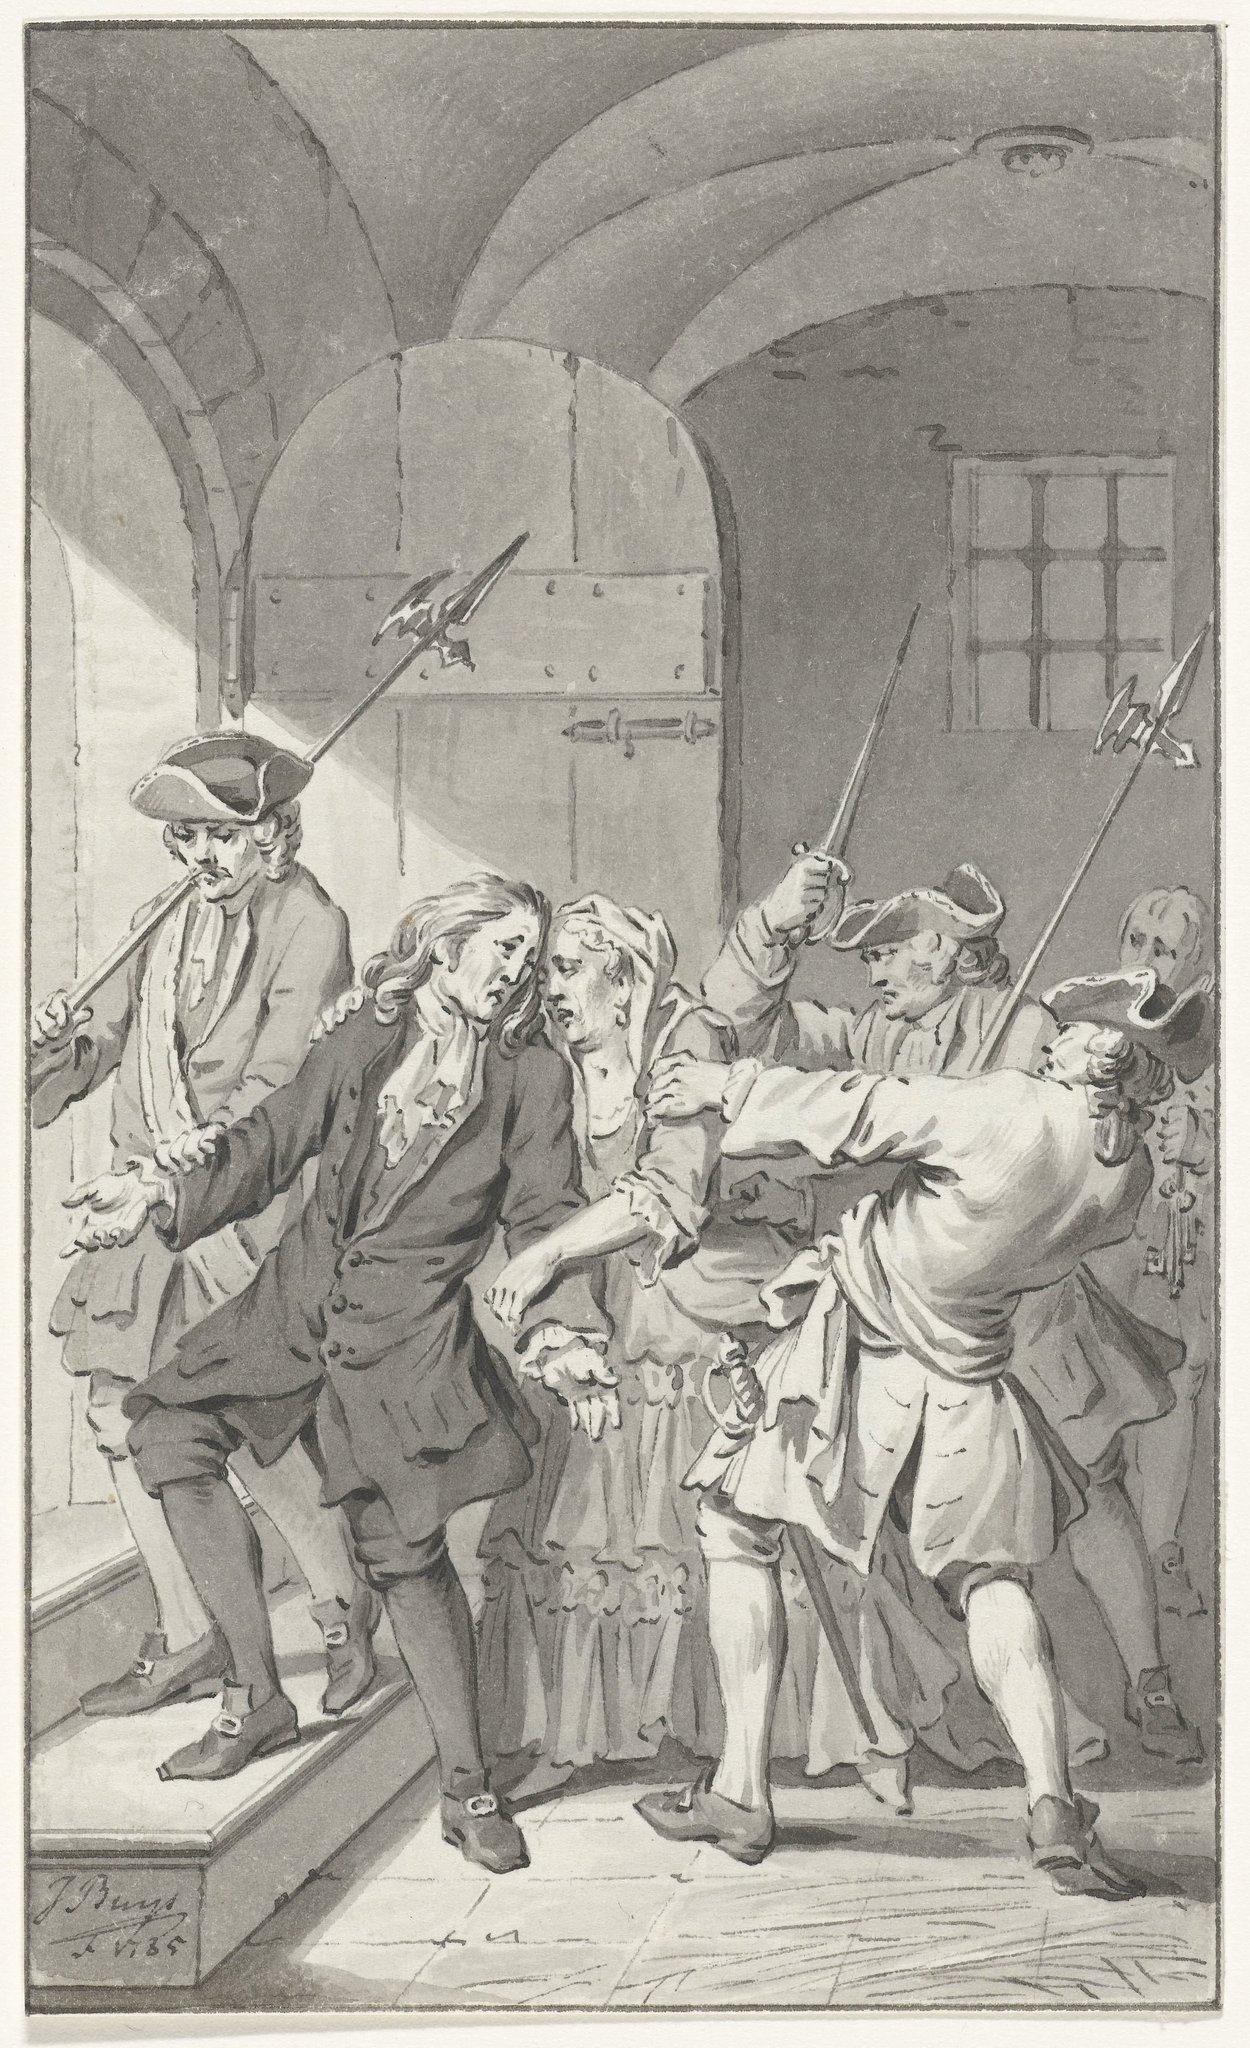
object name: historieplaat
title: Burgemeester Westerwijk te Goes uit de gevangenis geleid, 1692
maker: jacobus buys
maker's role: draughtsman, print maker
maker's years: 1724-1801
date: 1785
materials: ink, paper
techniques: brush, pen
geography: northern netherlands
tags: last talk with relatives (during last hours before execution), (person under sentence of death) on the way to the scaffold or place of execution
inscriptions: date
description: Burgemeester Adolph Westerwijk te Goes ter dood veroordeeld in een conflict met stadhouder Willem III. De straf werd echter omgezet in levenslang. In de voorstelling trekken soldaten de vrouw weg van de burgemeester op het moment dat hij uit de gevangenis wordt gebracht, 30 december 1692. Ontwerp voor een prent.